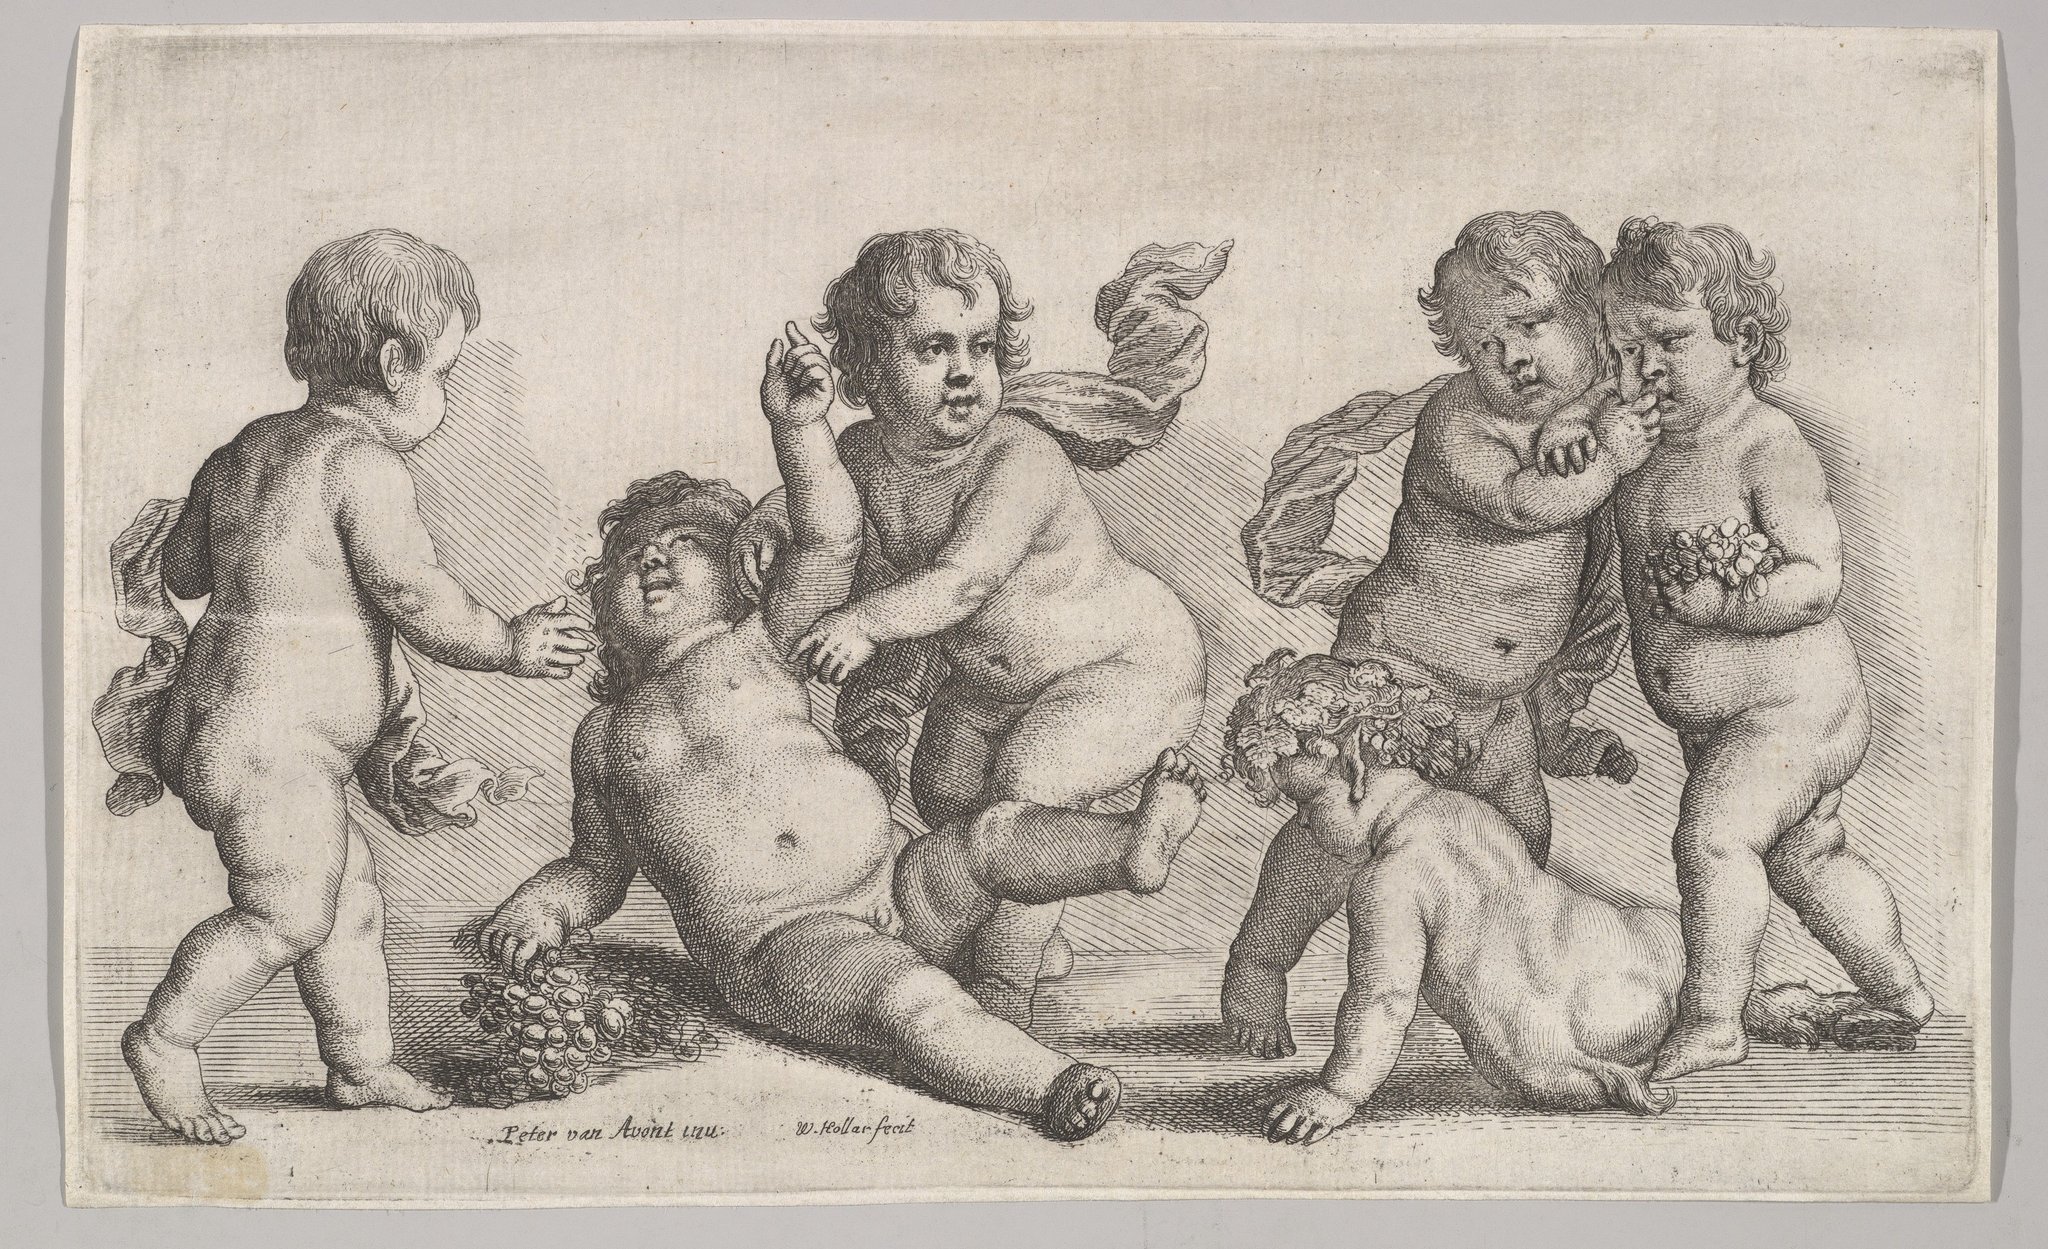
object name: print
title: Five boys and a satyr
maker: wenceslaus hollar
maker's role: artist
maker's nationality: bohemian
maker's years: 1607-1677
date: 1625-1677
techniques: etching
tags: boys,satyrs